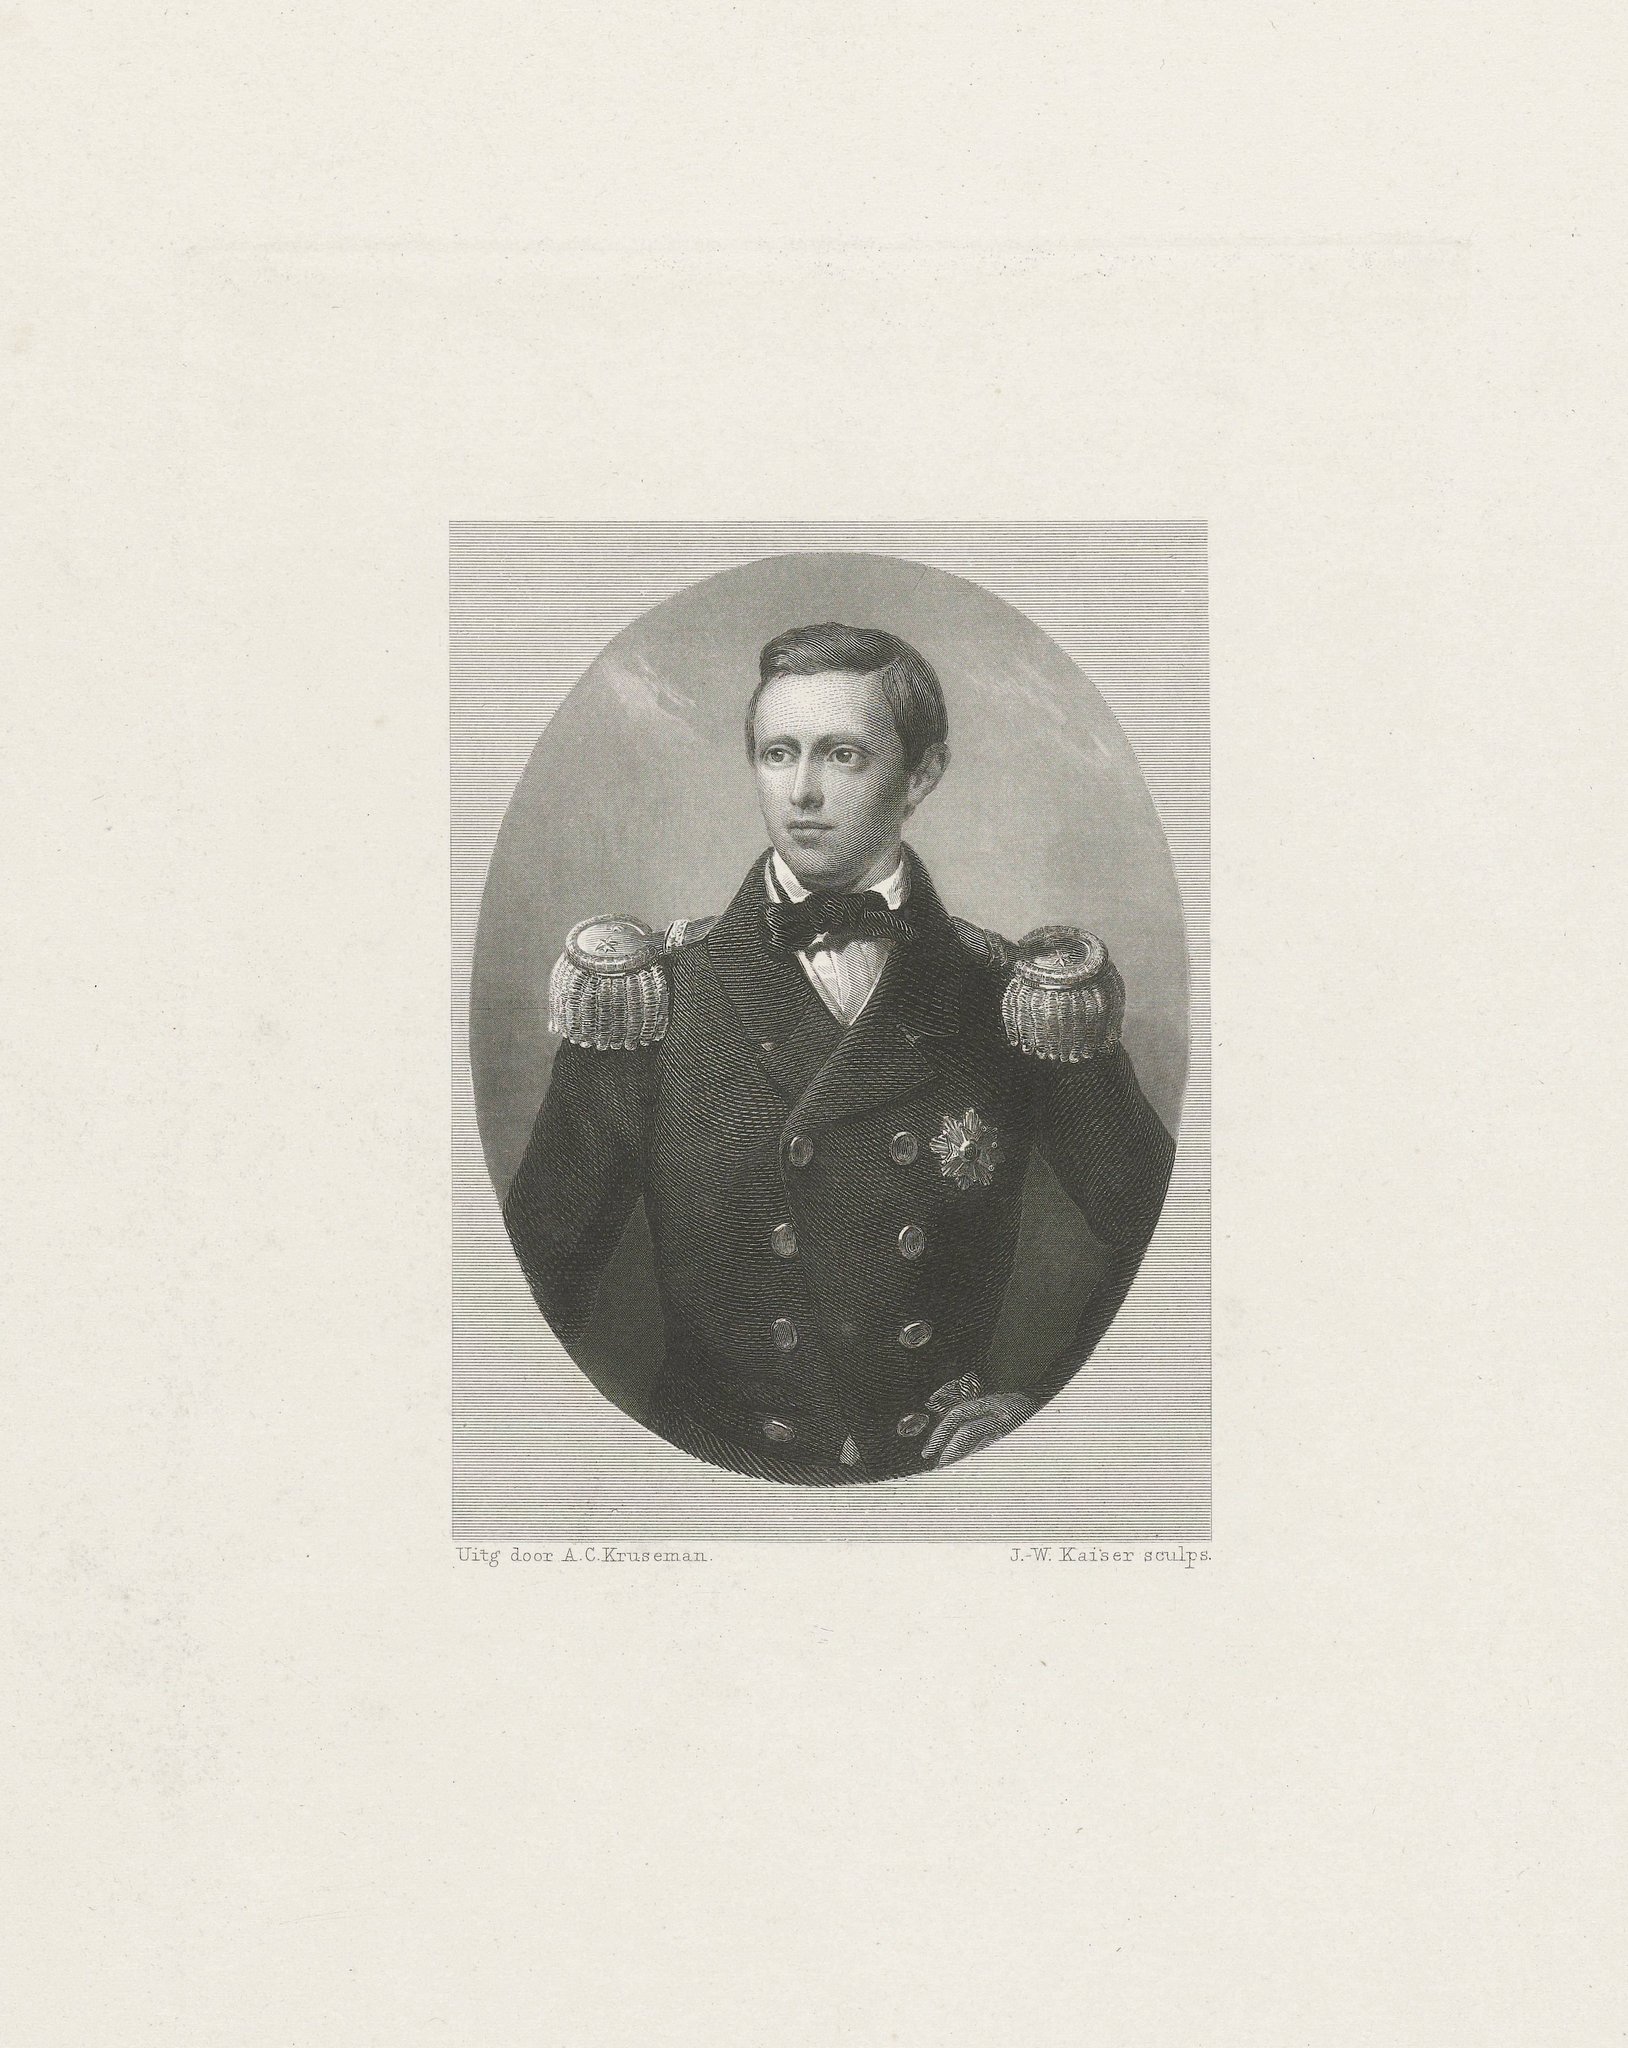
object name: print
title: Portret van Willem Frederik Hendrik, Prins der Nederlanden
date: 1830-1900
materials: paper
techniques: engraving, etching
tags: hendrik (prins der nederlanden)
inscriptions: collector's mark: Lugt 2228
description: Portret van Willem Frederik Hendrik, de oudste zoon van Willem III, Prins der Nederlanden, Prins van Oranje-Nassau. Zijn kostuum is versierd met epauletten en een medaille.